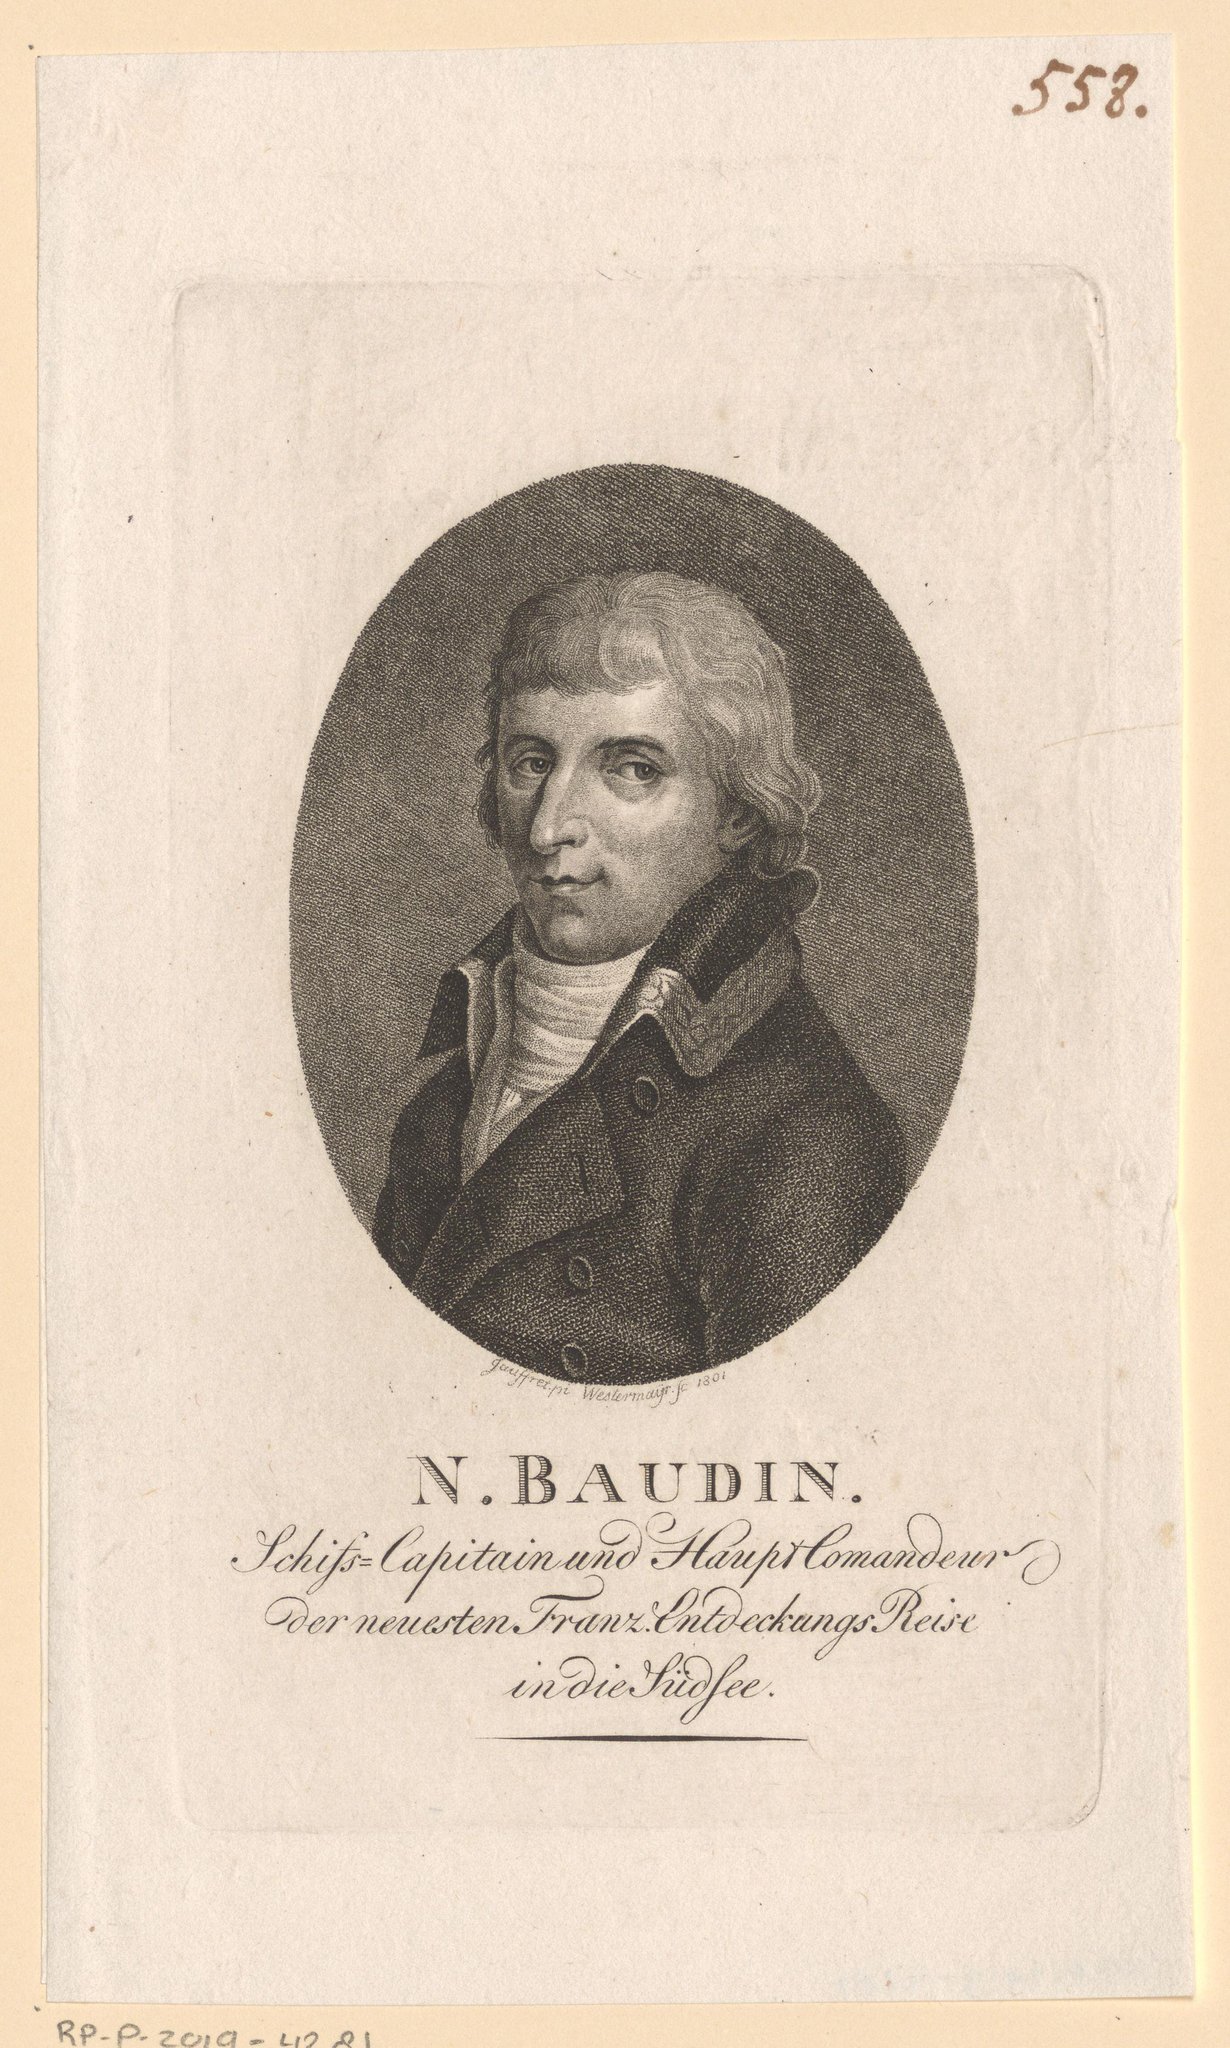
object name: print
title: Portret van Nicolas Thomas Baudin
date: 1801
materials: paper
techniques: etching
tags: historical persons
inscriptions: inscription: ‘558’